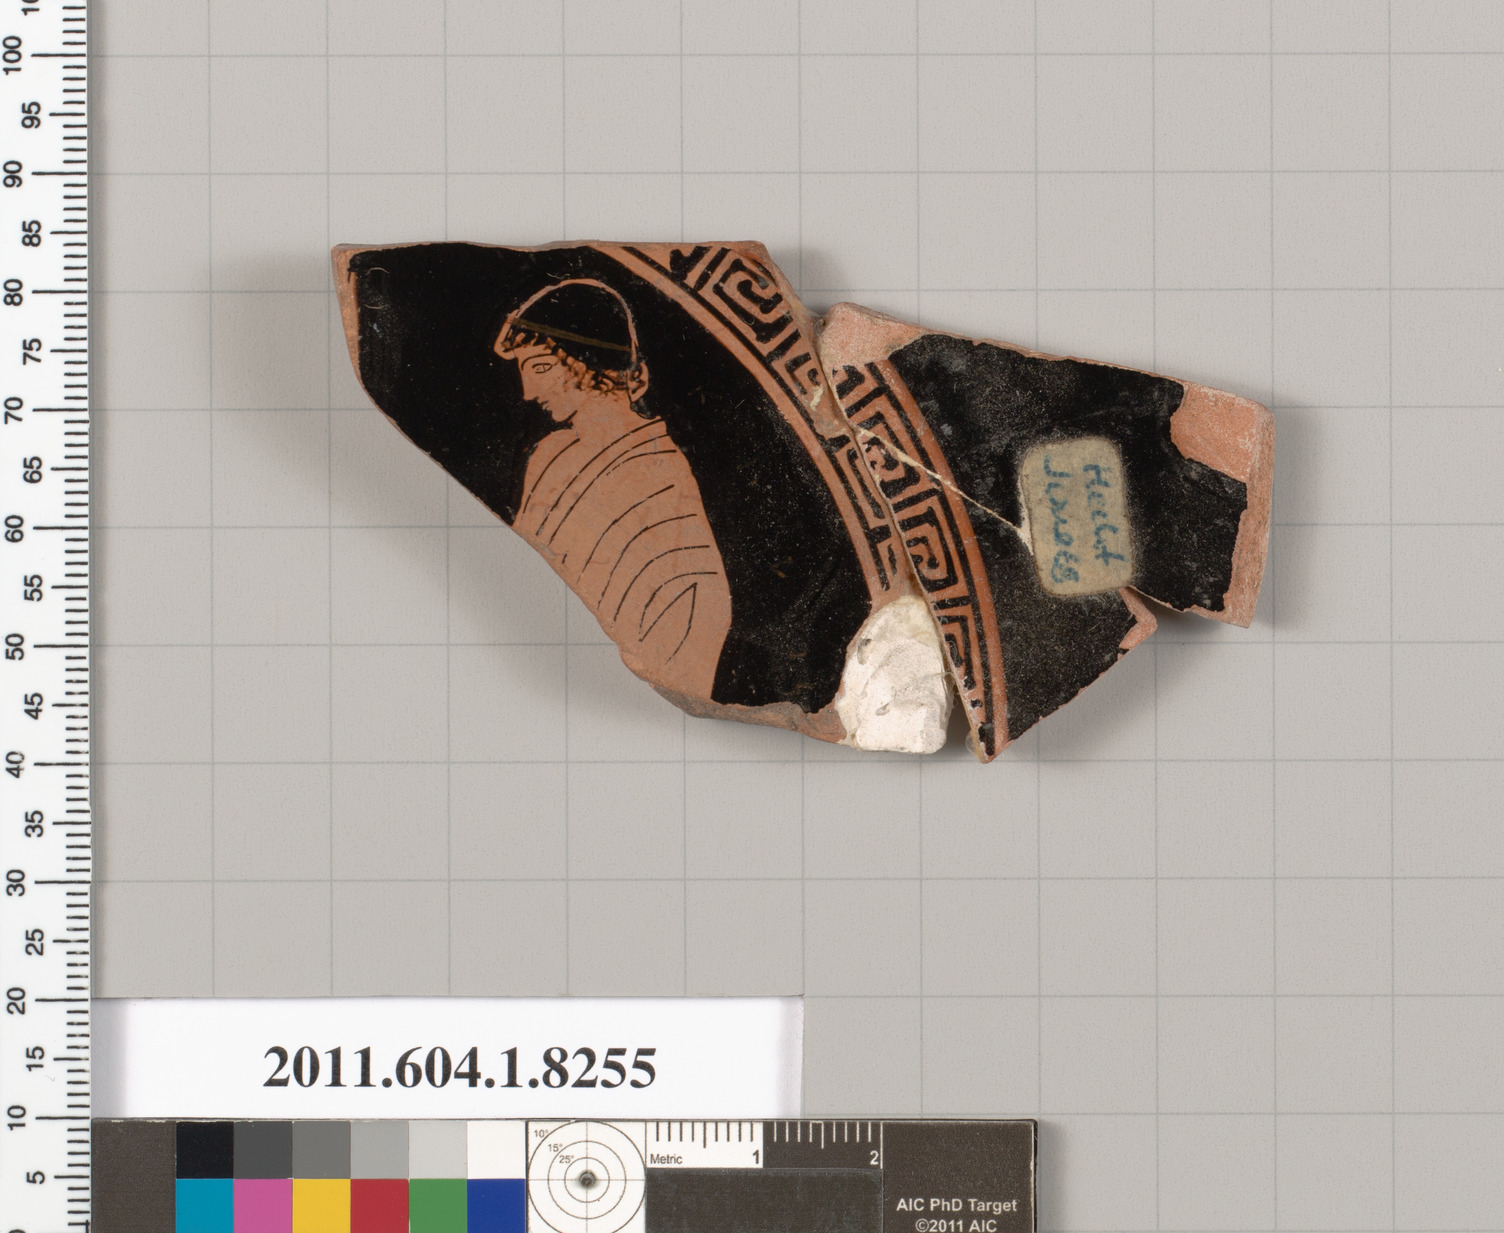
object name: kylix fragment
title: Terracotta fragment of a kylix (drinking cup)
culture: greek, attic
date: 460-450 BCE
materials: terracotta